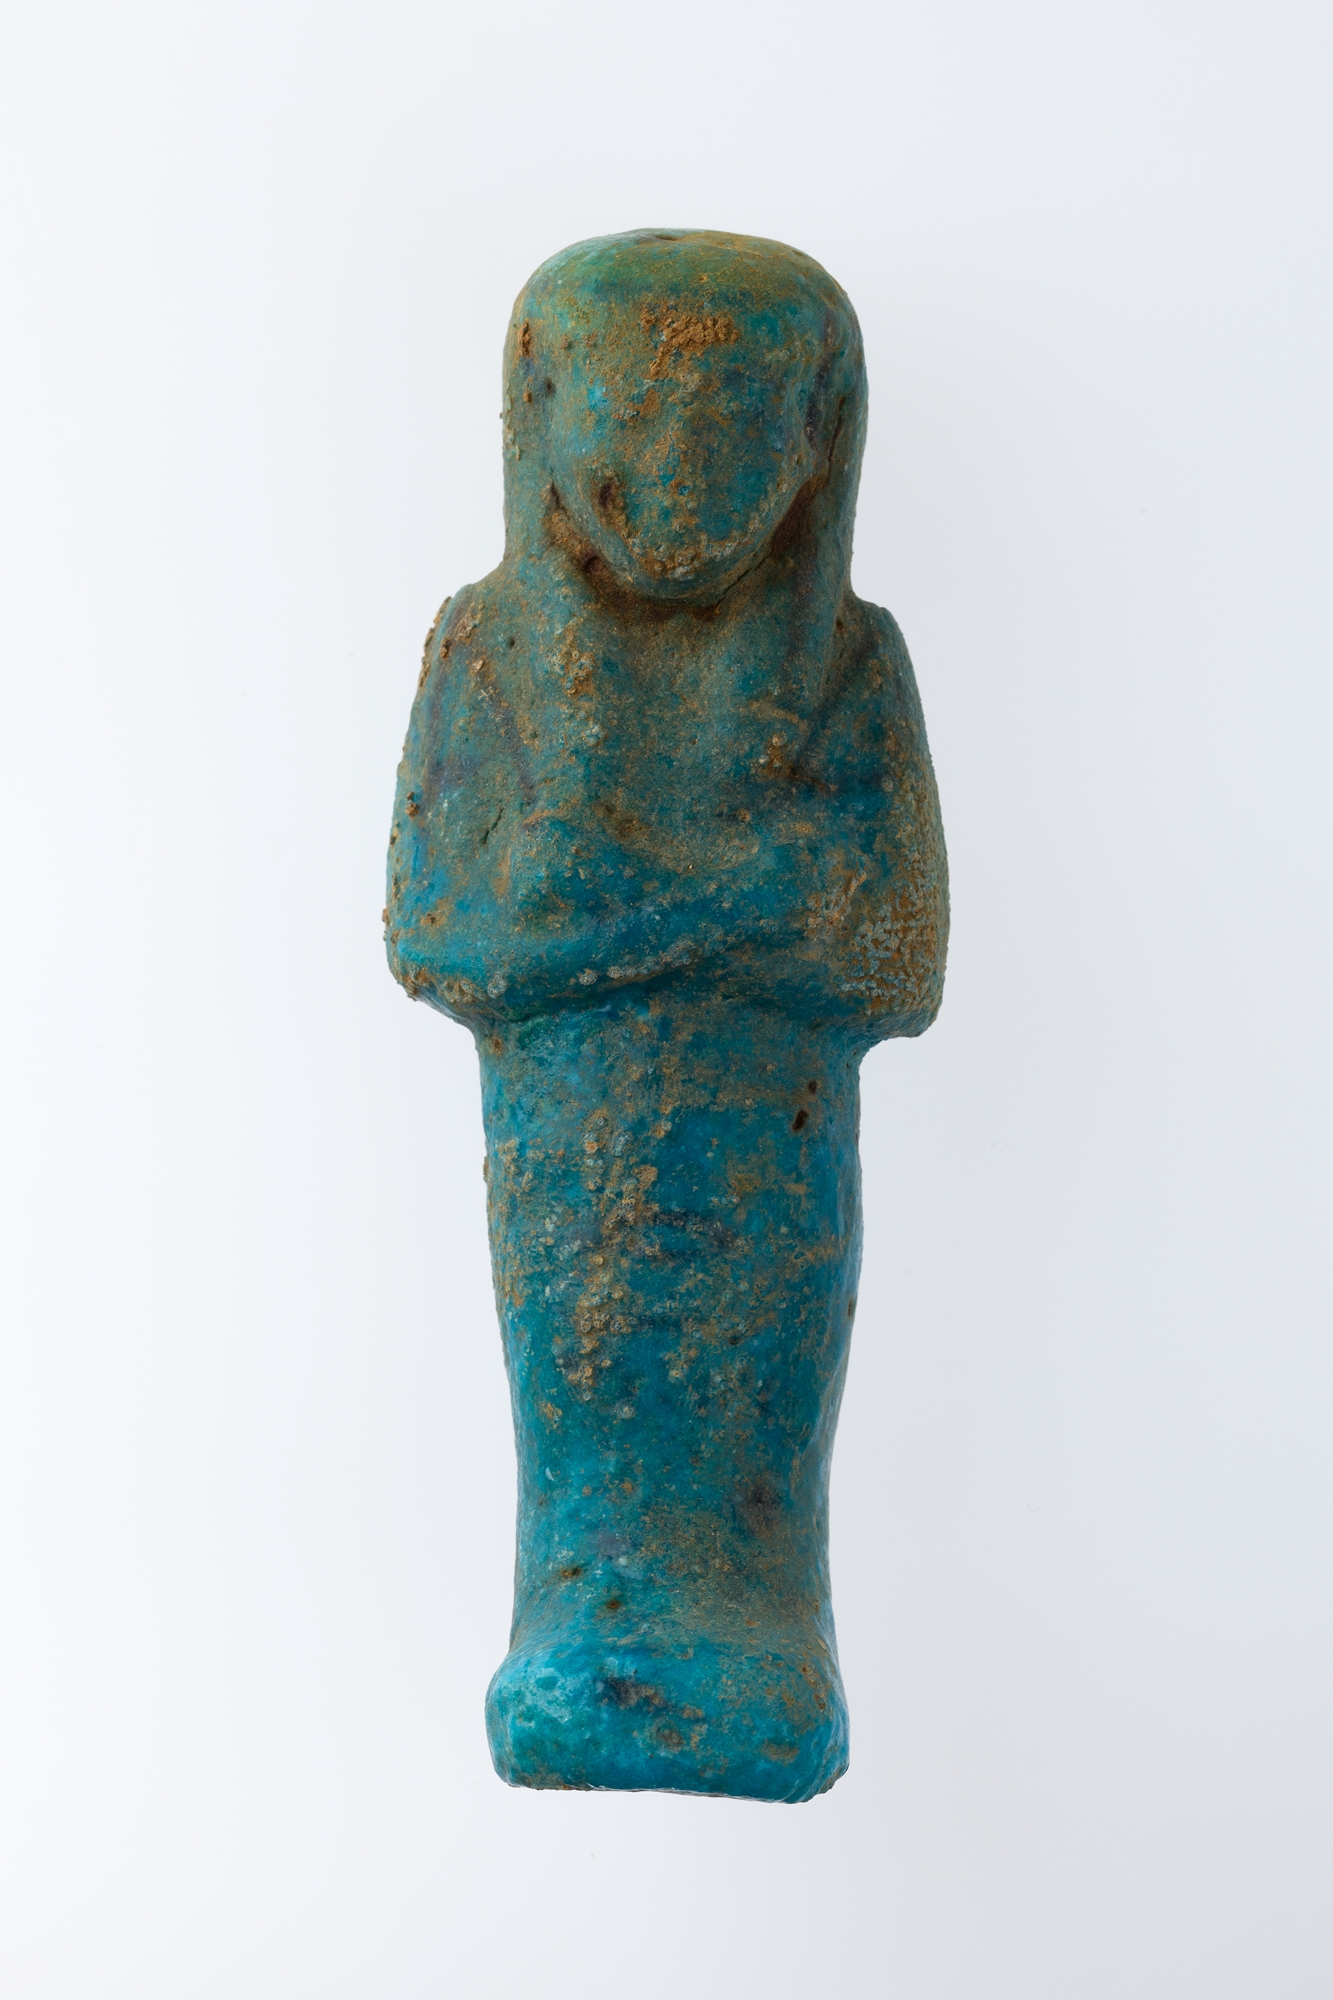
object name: shabti, henettawy c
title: Worker Shabti of Henettawy (C), Daughter of Isetemkheb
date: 990-970 BCE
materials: faience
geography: egypt